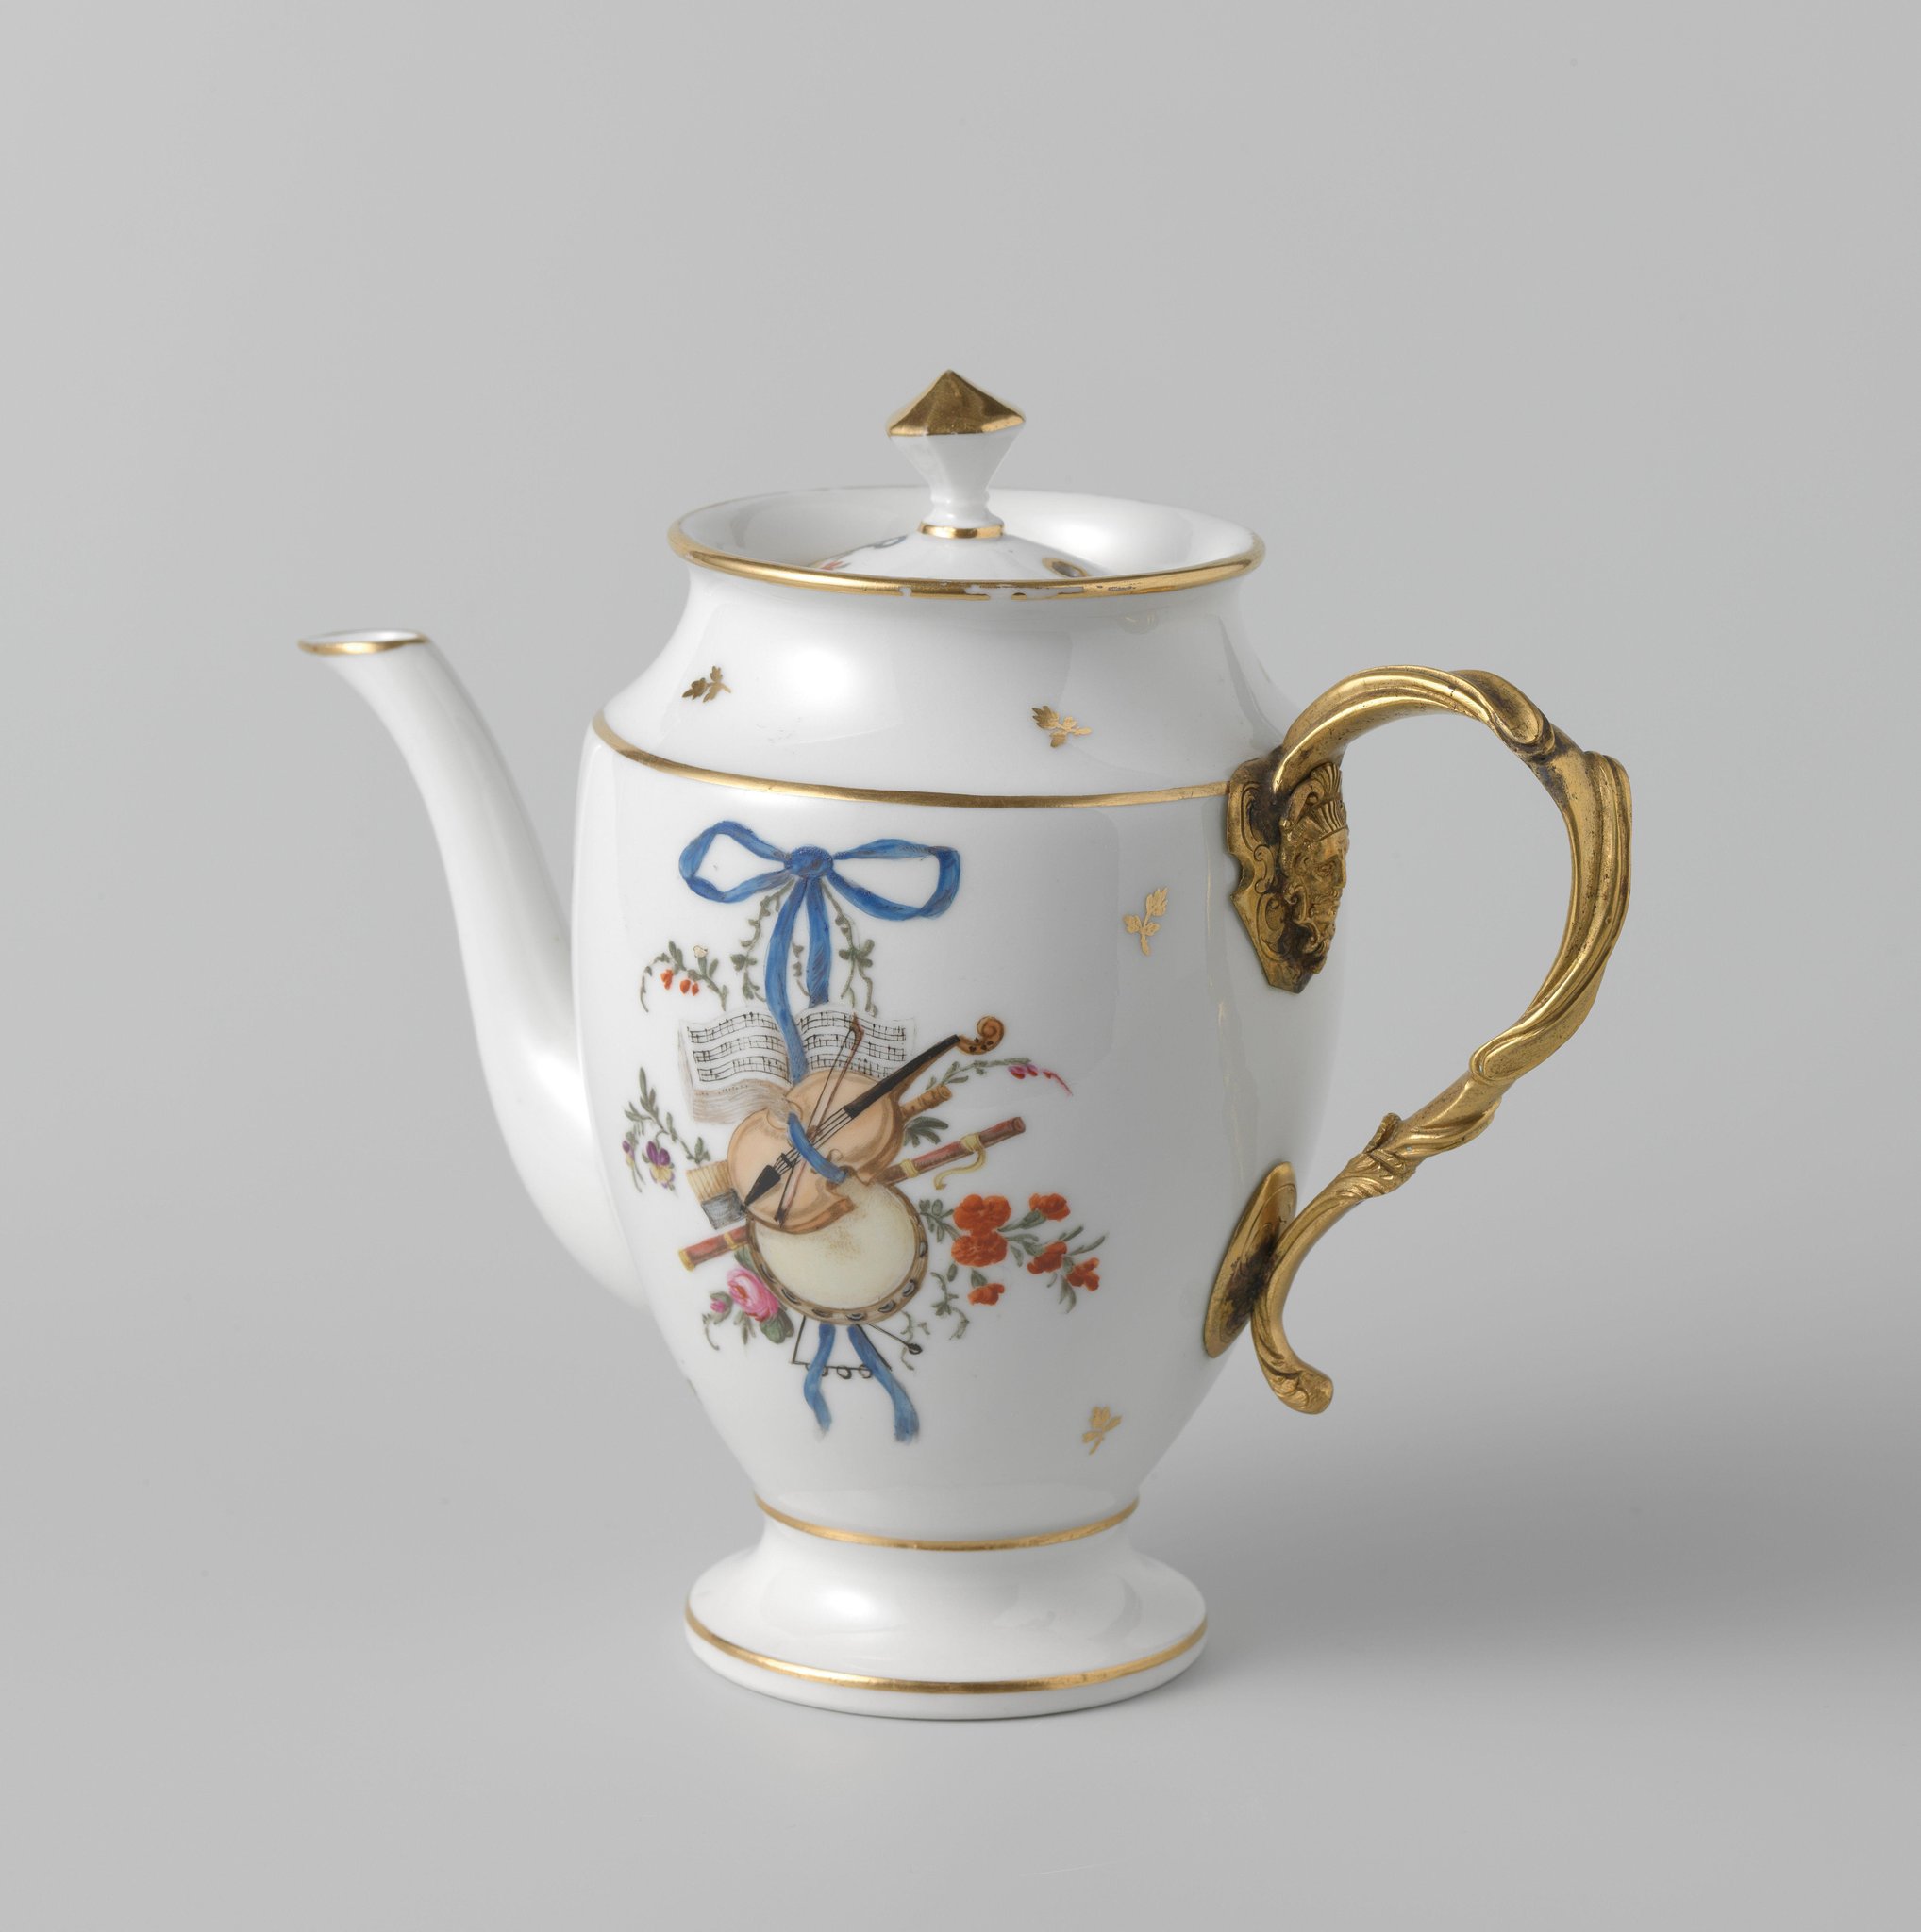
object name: teapot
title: Theepot, decoratie van attributen aan gestrikte linten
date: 1809-1814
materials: copper, porcelain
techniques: painted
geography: nieuwer-amstel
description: Een theepot veelkleurig beschilderd met attributen hangend aan blauwe strikken. Aan één zijde een compositie van muziekinstrumenten en aan de andere zijde een compositie van vaandels, een trommel en geweren. De pot heeft een versierd oor van koper. Gemerkt in zwart: Amstel